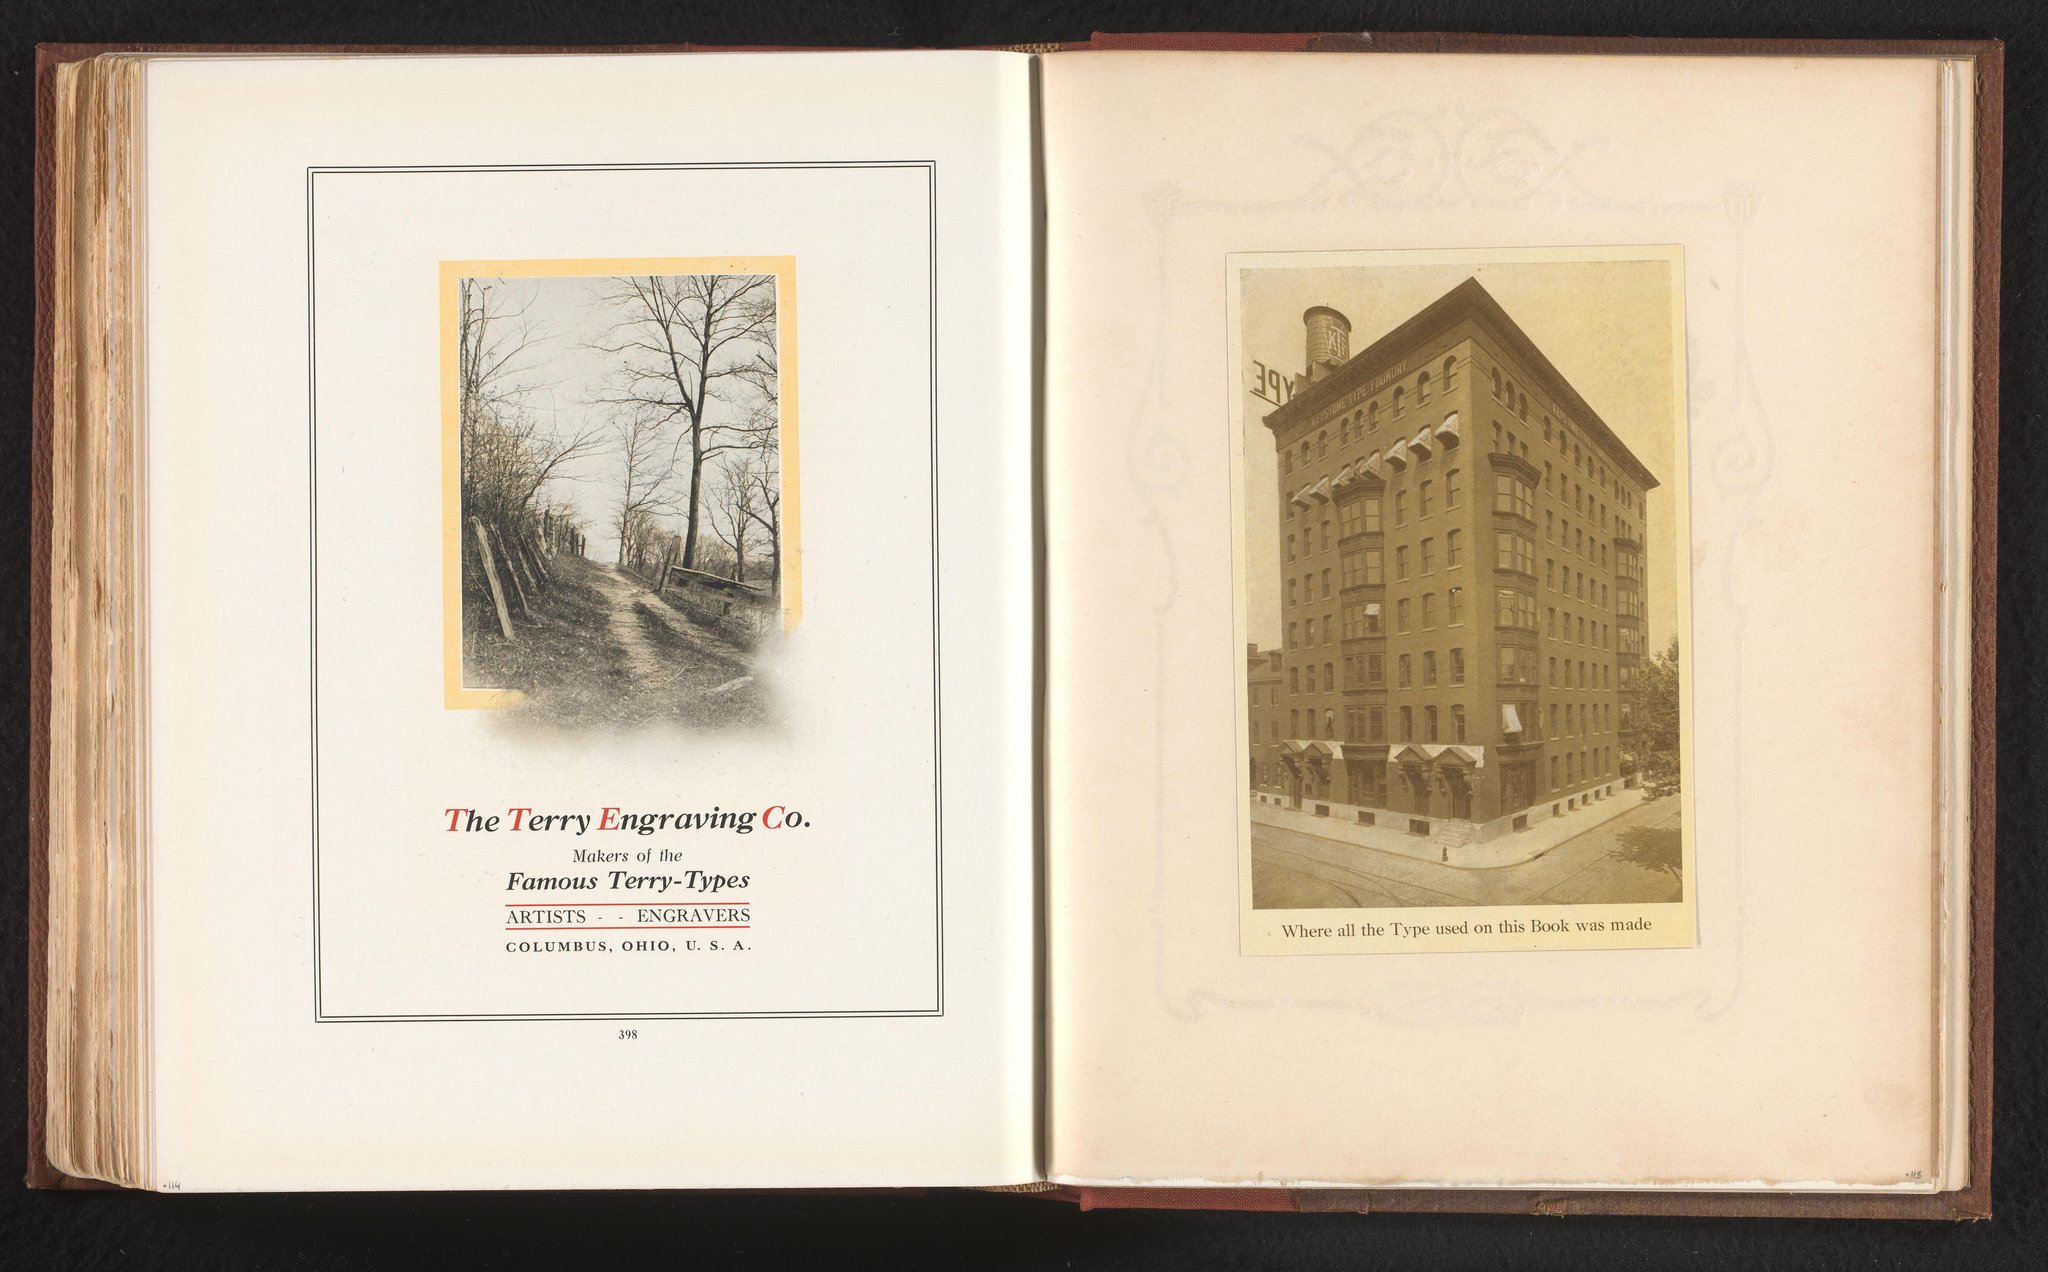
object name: advertisement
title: Reclame voor The Terry Engraving Co., Columbus, Ohio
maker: Anonymous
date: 1904-1909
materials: paper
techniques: autotype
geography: columbus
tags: advertising, road, path